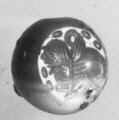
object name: stamp seal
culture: sasanian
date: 201-700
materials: stone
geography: iran or mesopotamia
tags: animals